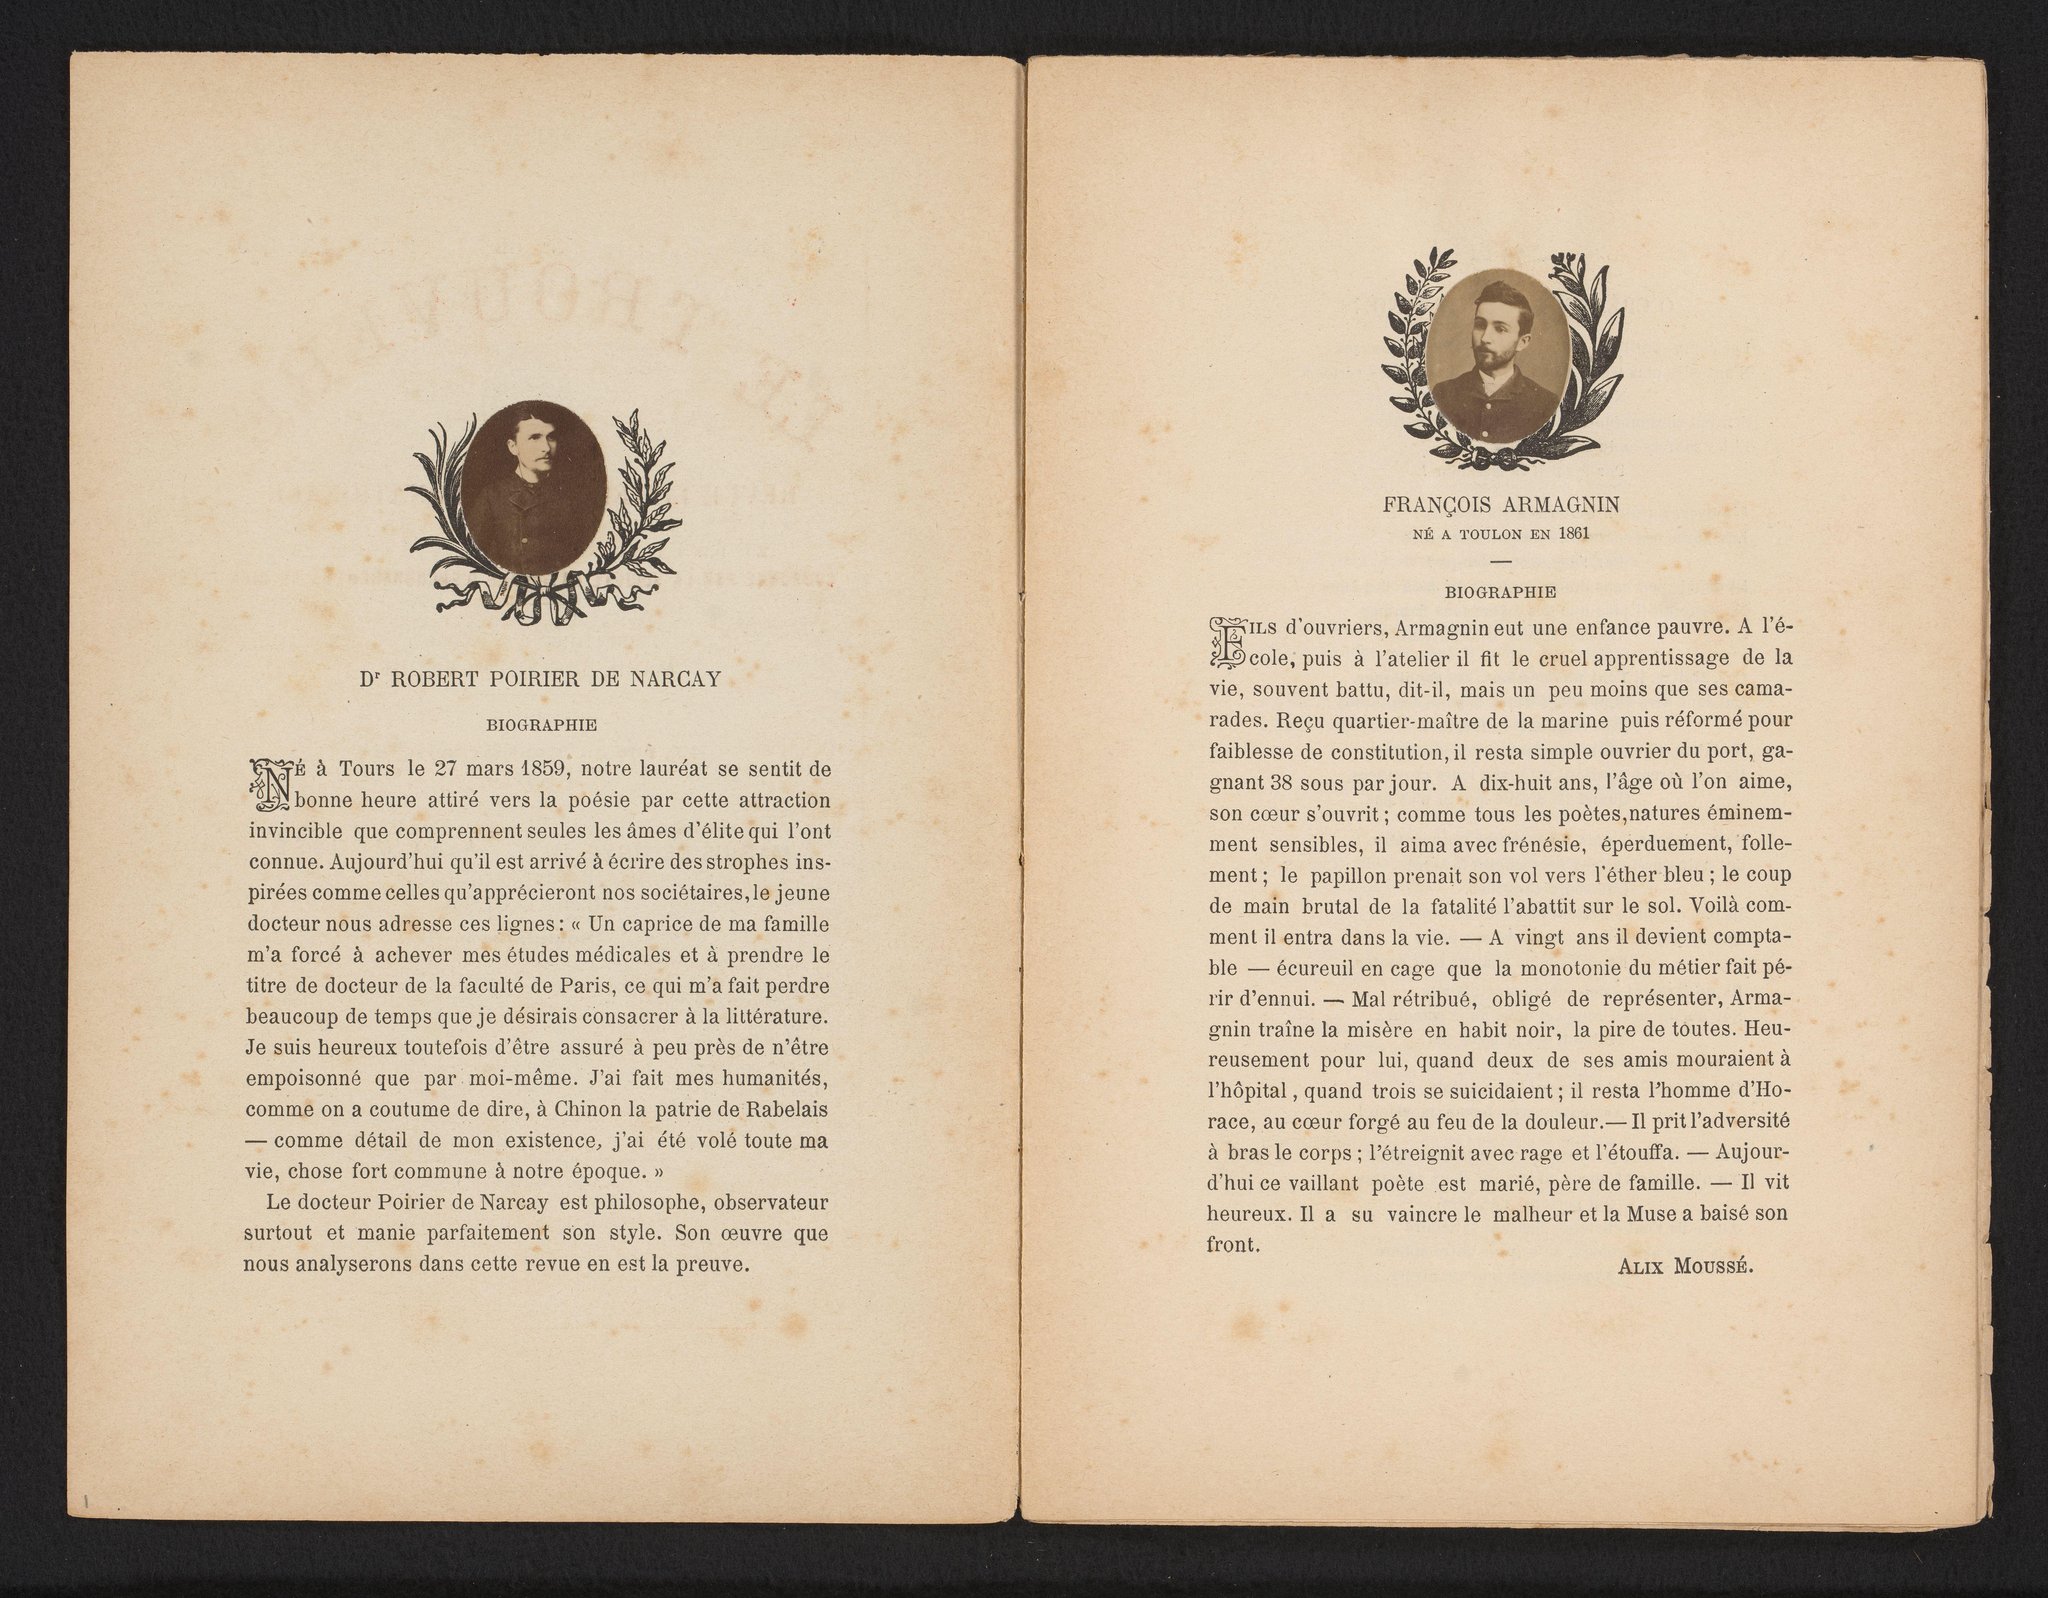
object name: photograph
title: Portret van Robert Poirier de Narçay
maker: Anonymous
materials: photographic support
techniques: albumen print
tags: politician, historical persons